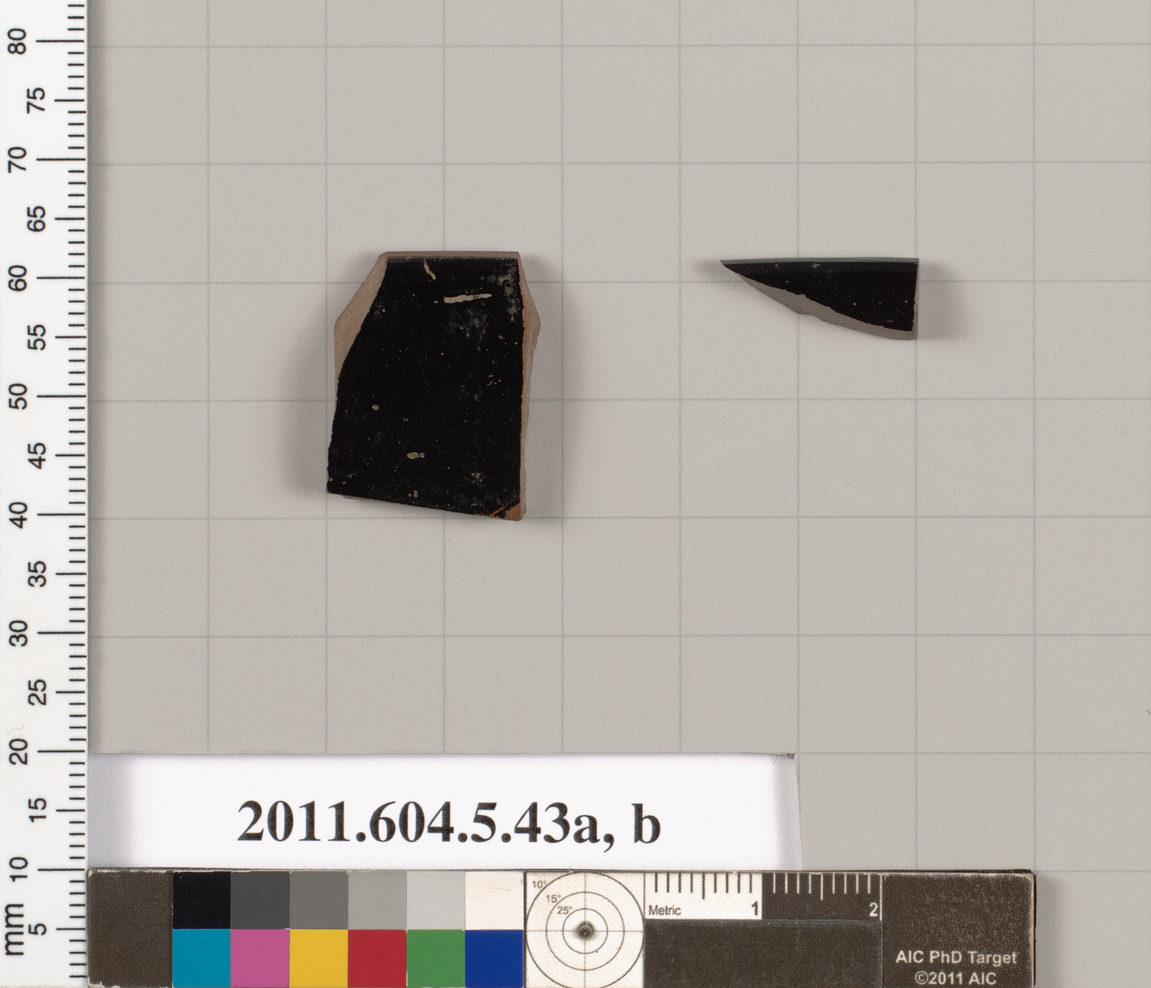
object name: kylix fragment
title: Terracotta rim fragments of kylikes (drinking cups)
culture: greek, attic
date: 500-401 BCE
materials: terracotta